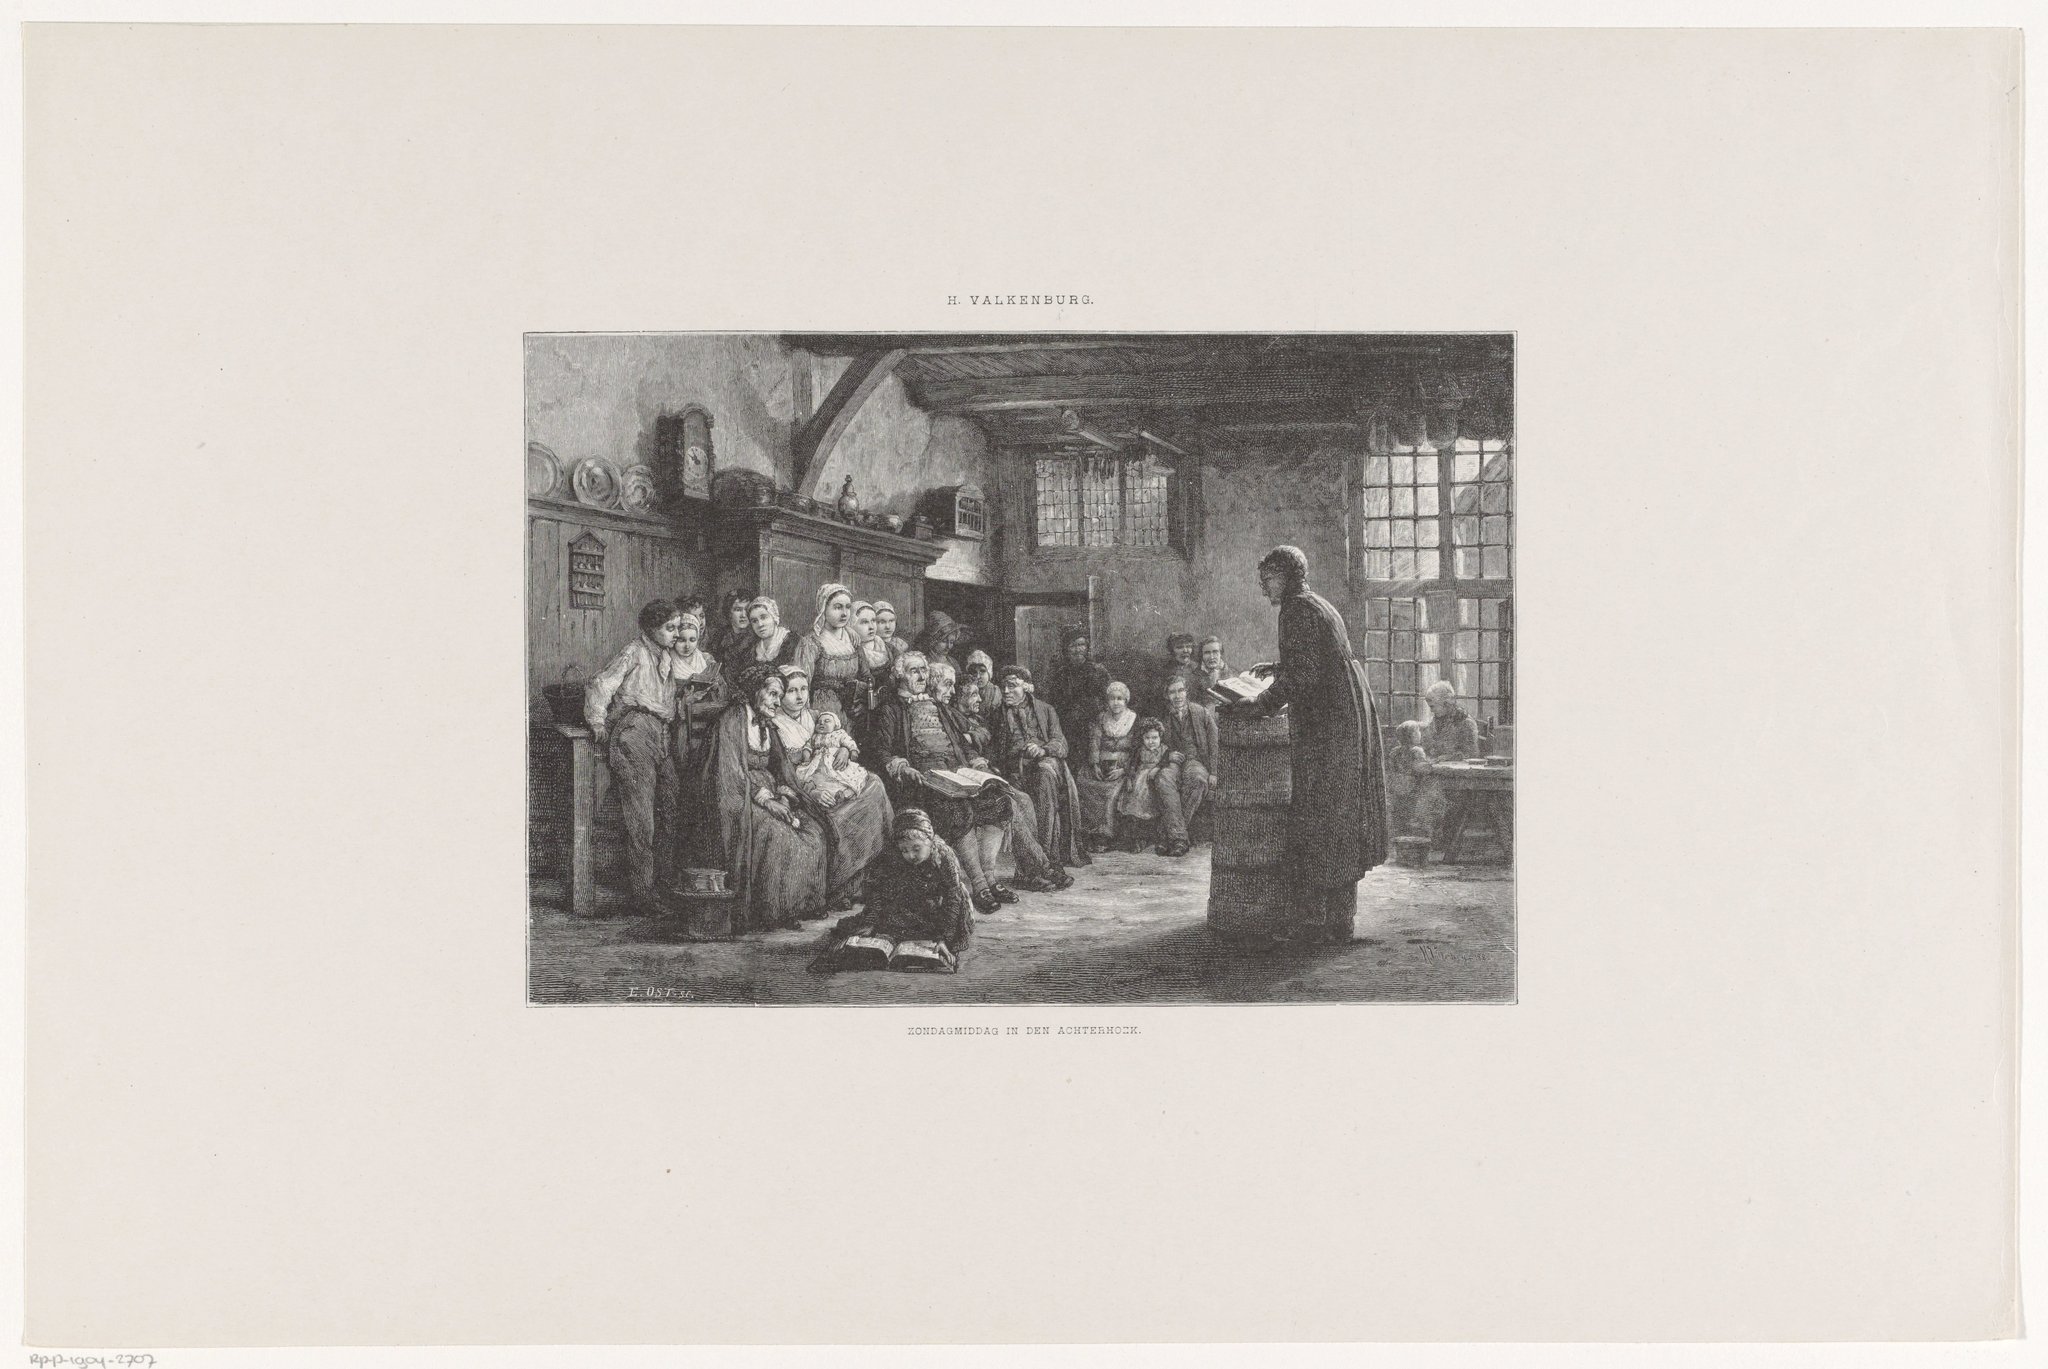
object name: print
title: Zondagmiddag in den Achterhoek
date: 1883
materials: paper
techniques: engraving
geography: belgium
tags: book, sunday, afternoon, person addressing a group, orator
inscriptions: collector's mark: Lugt 2228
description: In een grote kamer van een woonhuis zitten tientallen figuren met boeken op schoot te luisteren naar een man. Hij staat achter een houten ton en heeft ook een boek voor zich.